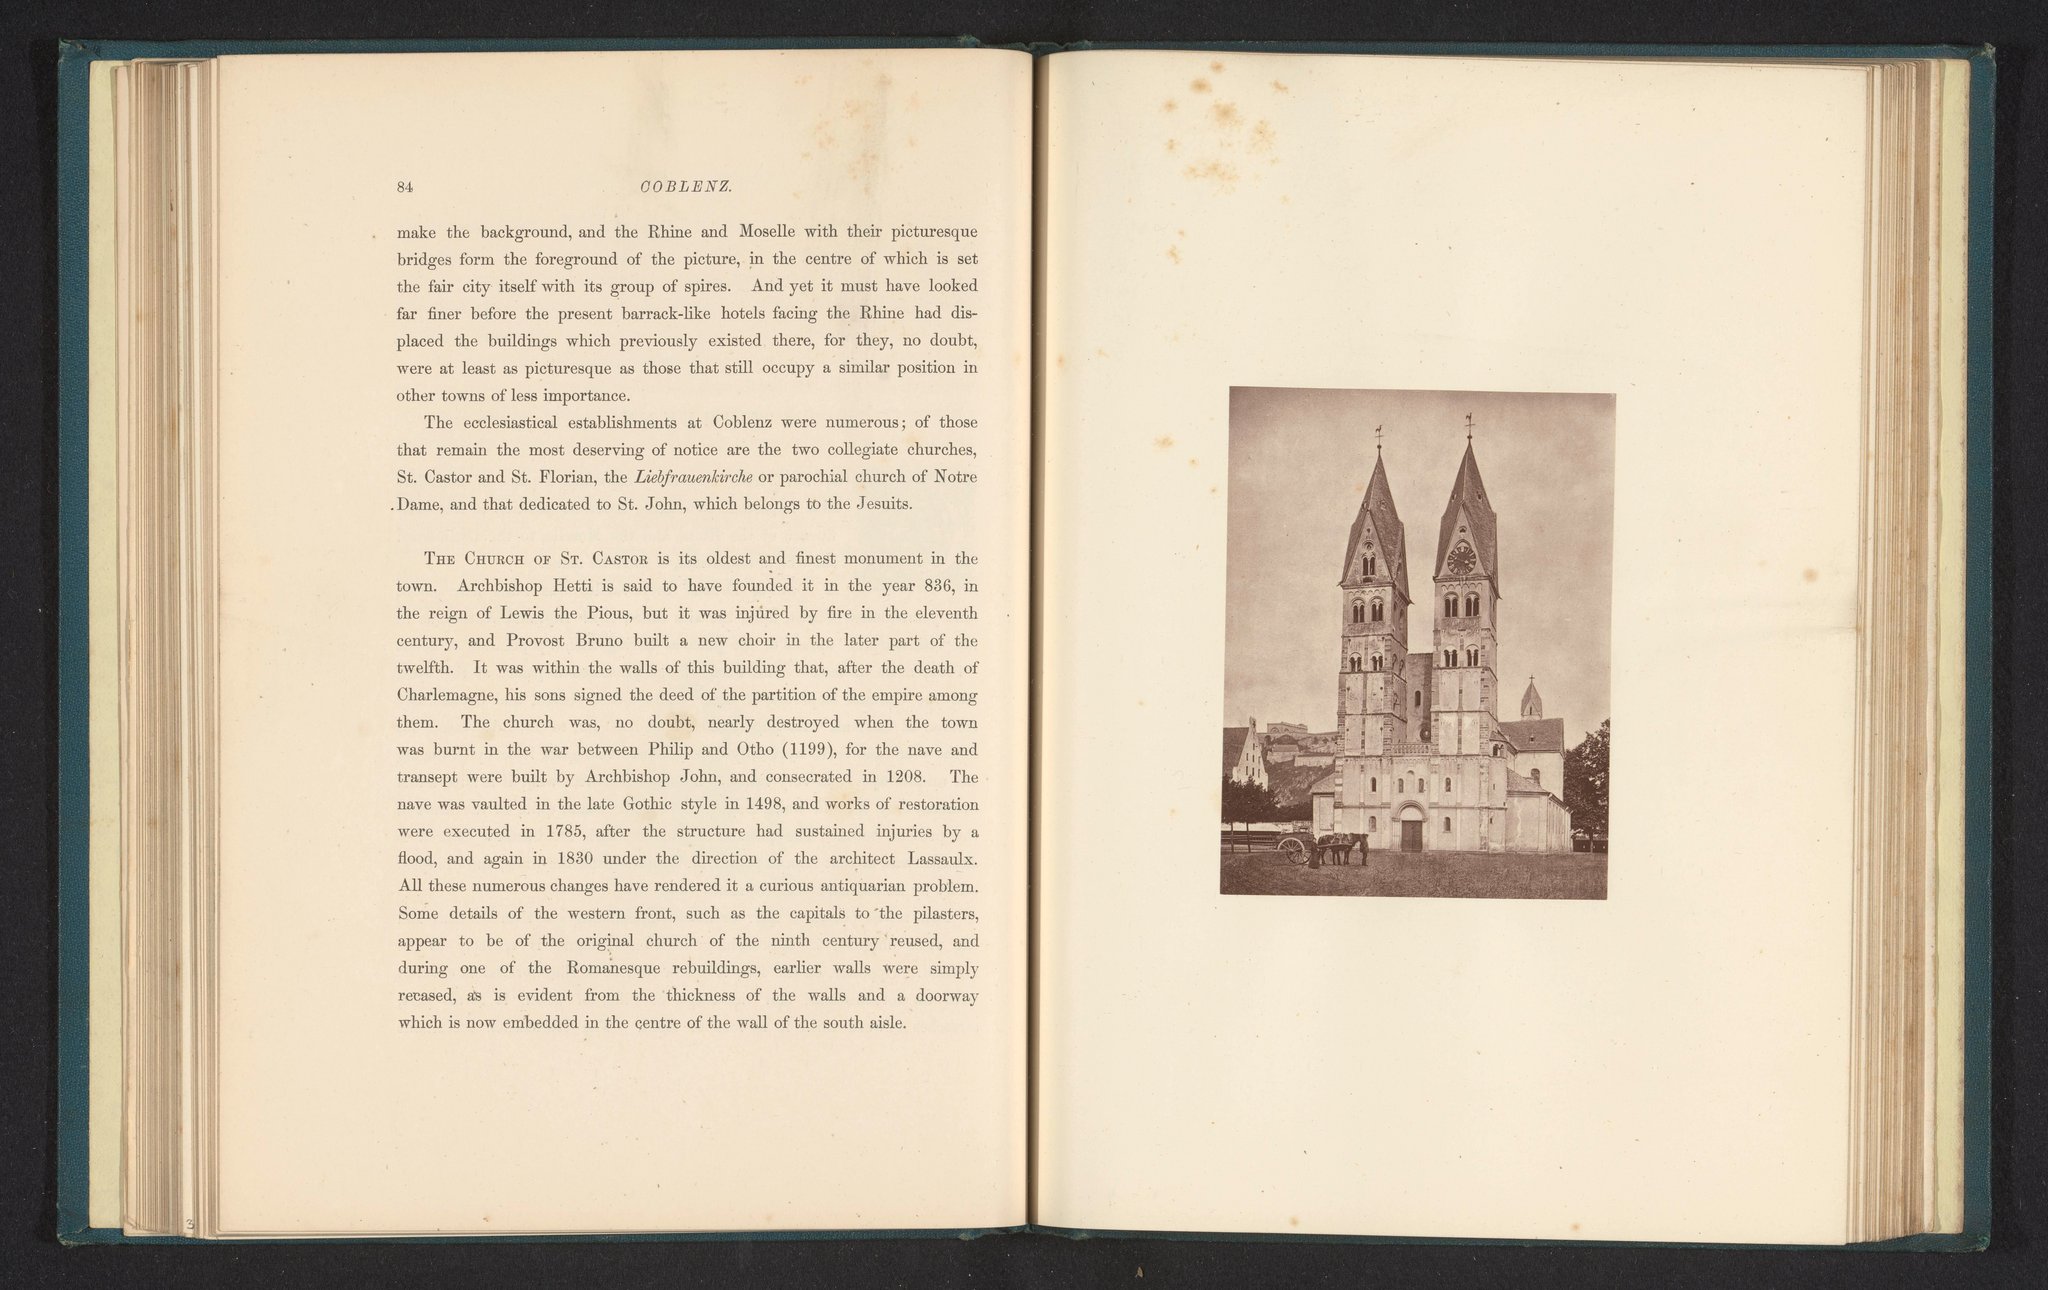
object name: page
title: Gezicht op de Sint-Kastorbasiliek in Koblenz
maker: Anonymous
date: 1858-1868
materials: paper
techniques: woodburytype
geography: koblenz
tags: church (exterior)